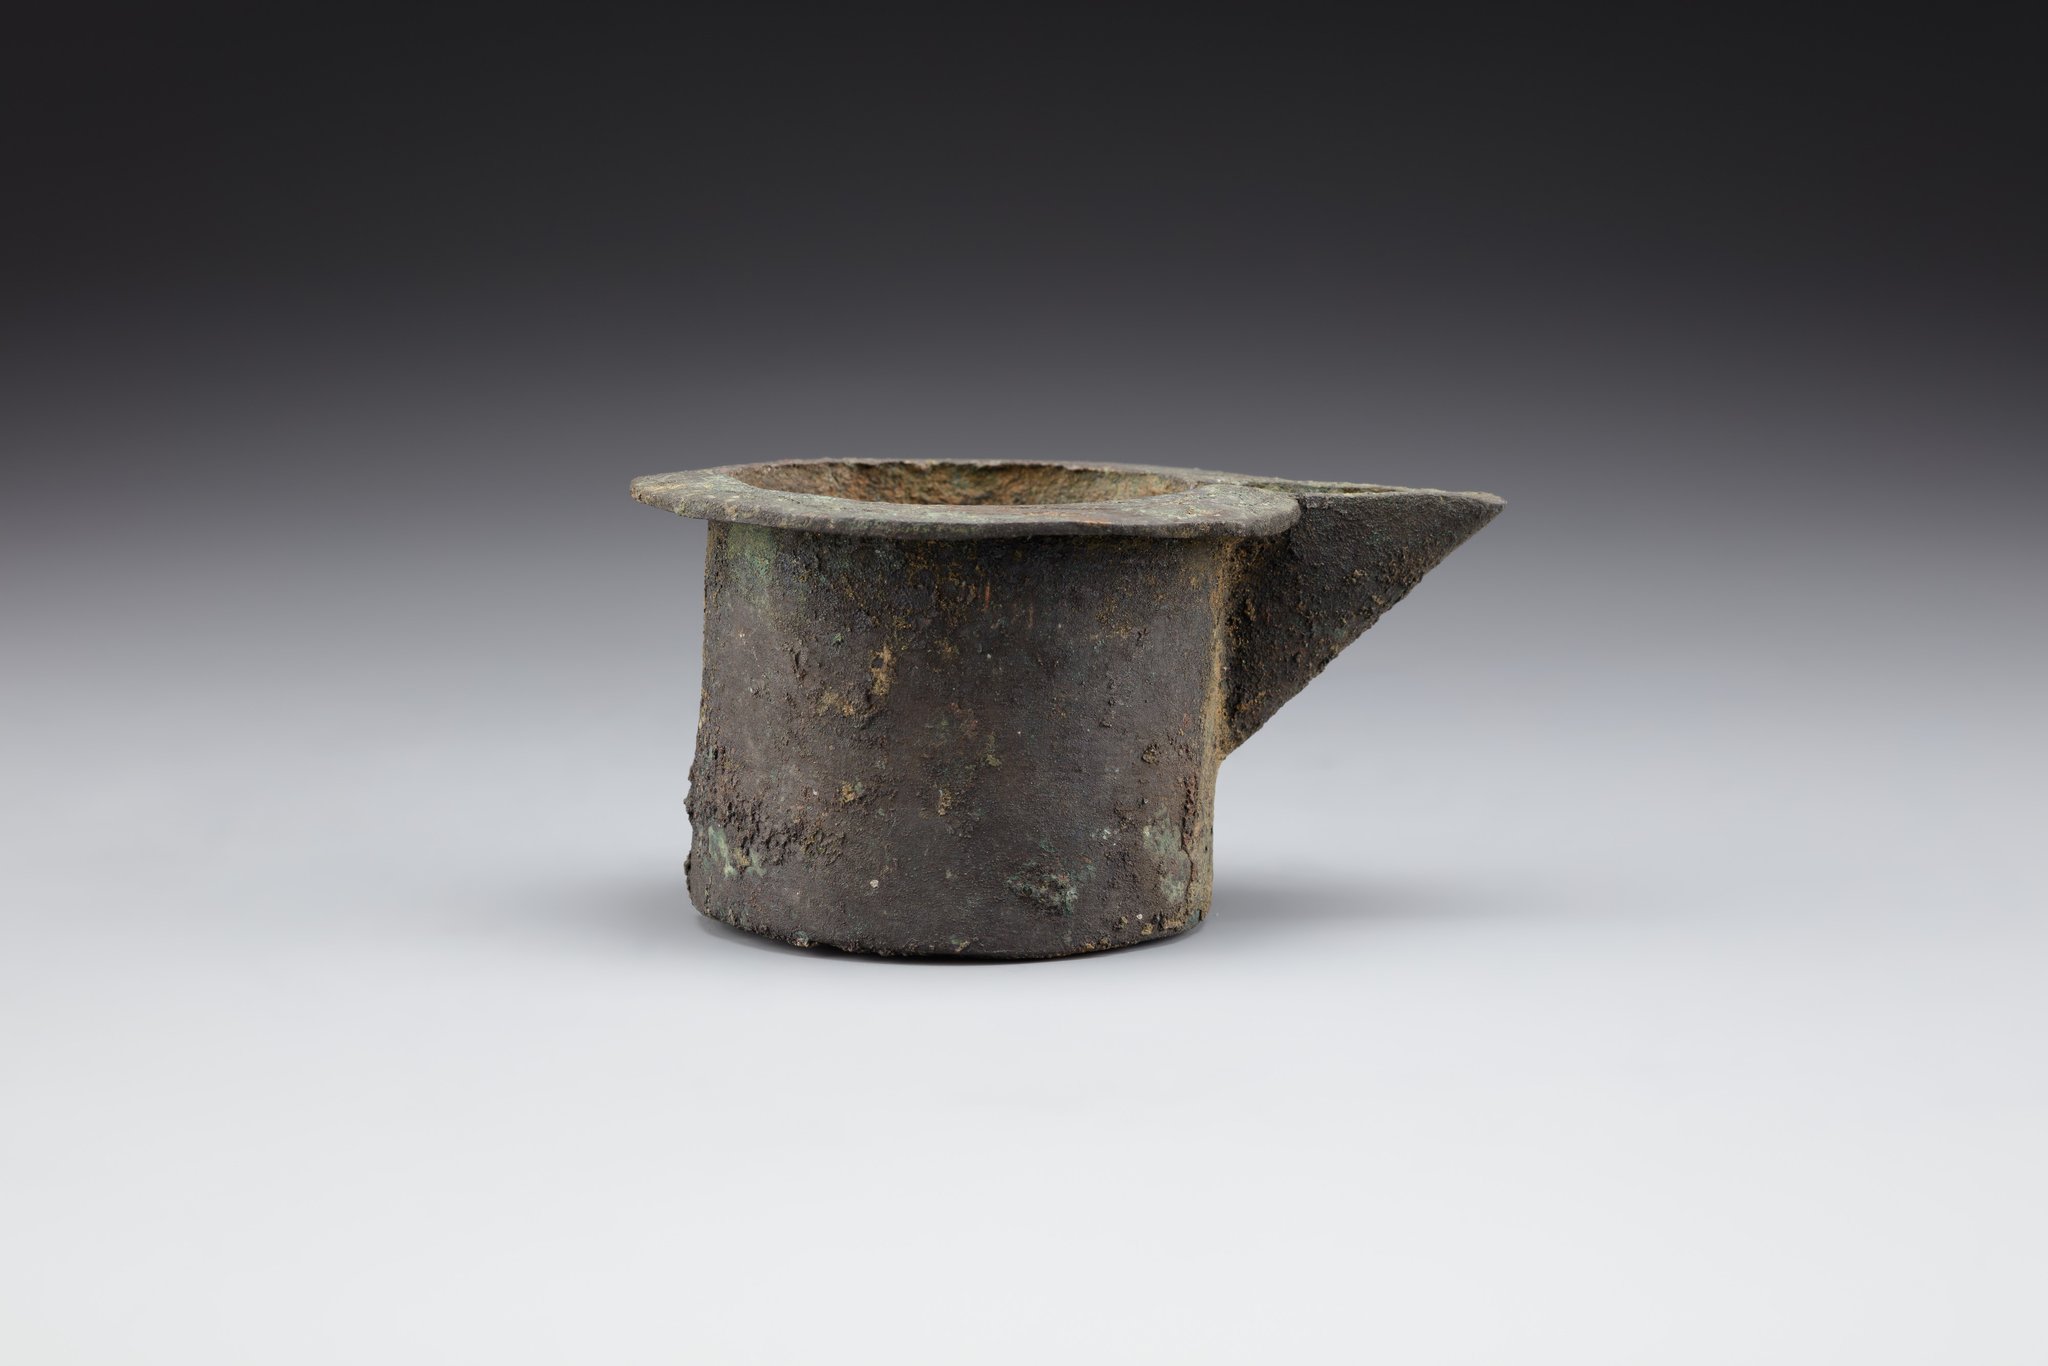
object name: pot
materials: bronze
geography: nubia